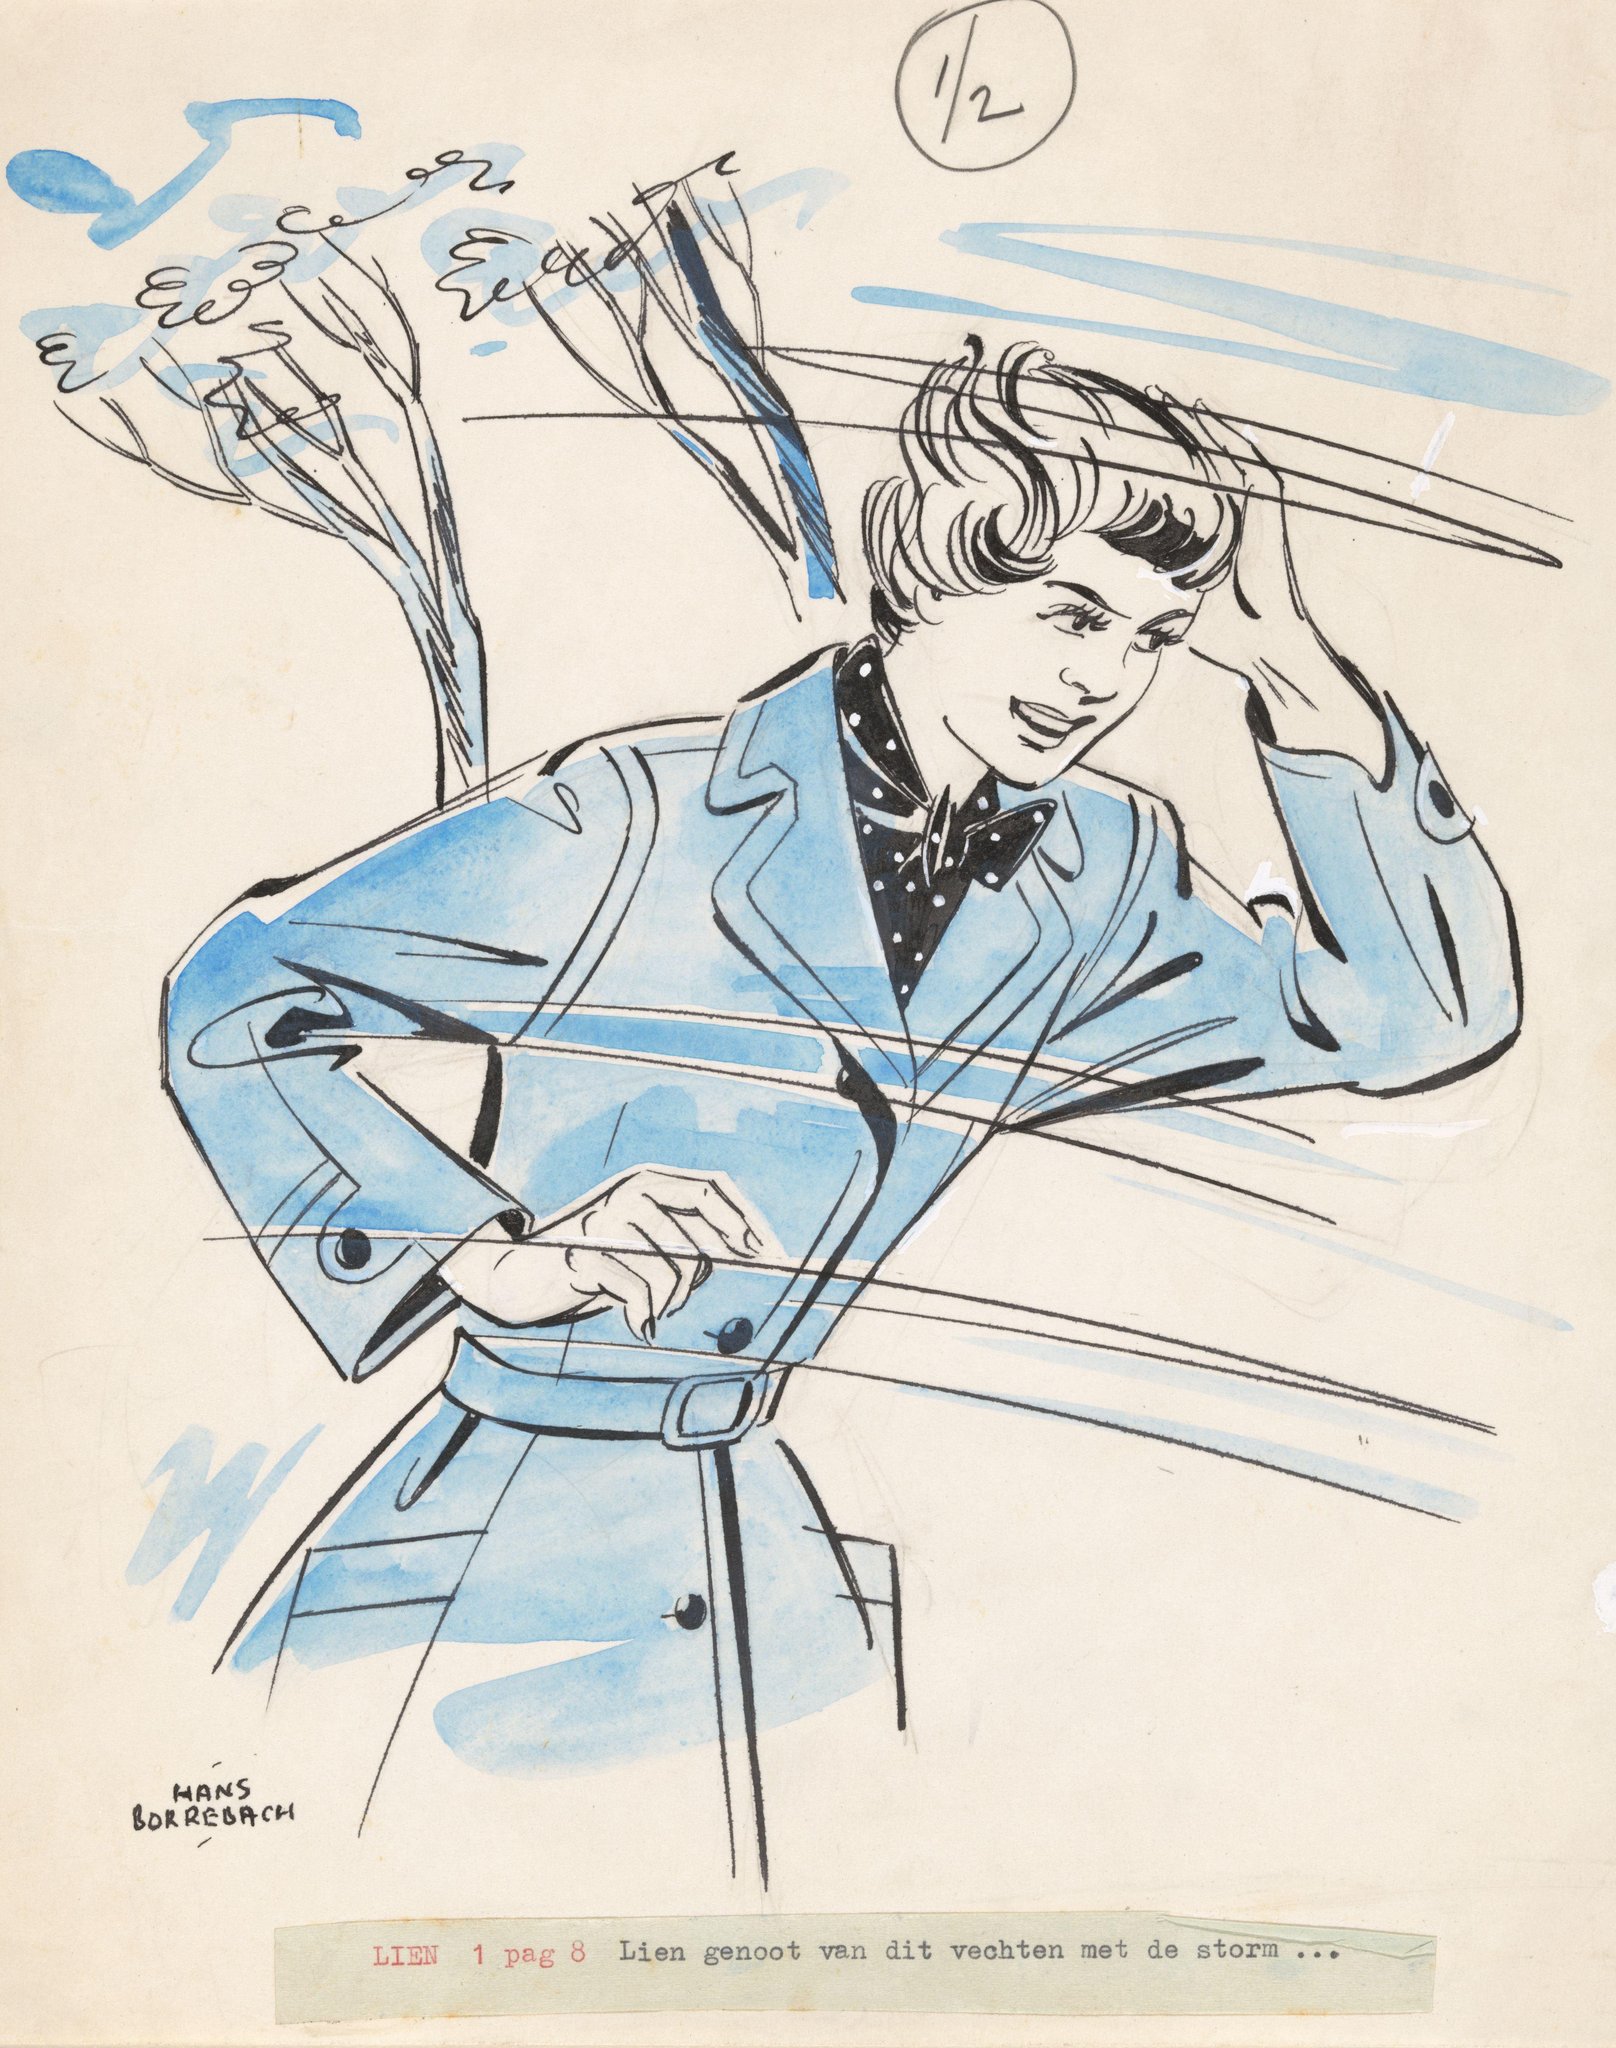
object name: drawing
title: Lien loopt door een storm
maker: hans borrebach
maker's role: draughtsman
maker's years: 1903-1991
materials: paint, ink, paper, pencil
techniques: brush, pen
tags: adolescent, young woman, maiden, storm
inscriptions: :, signature: ‘HANS/ BORREBACH’, annotation: ‘LIEN 1 pag 8 Lien genoot van dit vechten met de storm ...’, collector's mark: Lugt 2228a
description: Lien, in een jas met ceintuur, loopt tegen een stormwind in. Ze grijpt met haar linkerhand naar haar haar. Op de achtergrond zwiepen twee bomen in de wind.